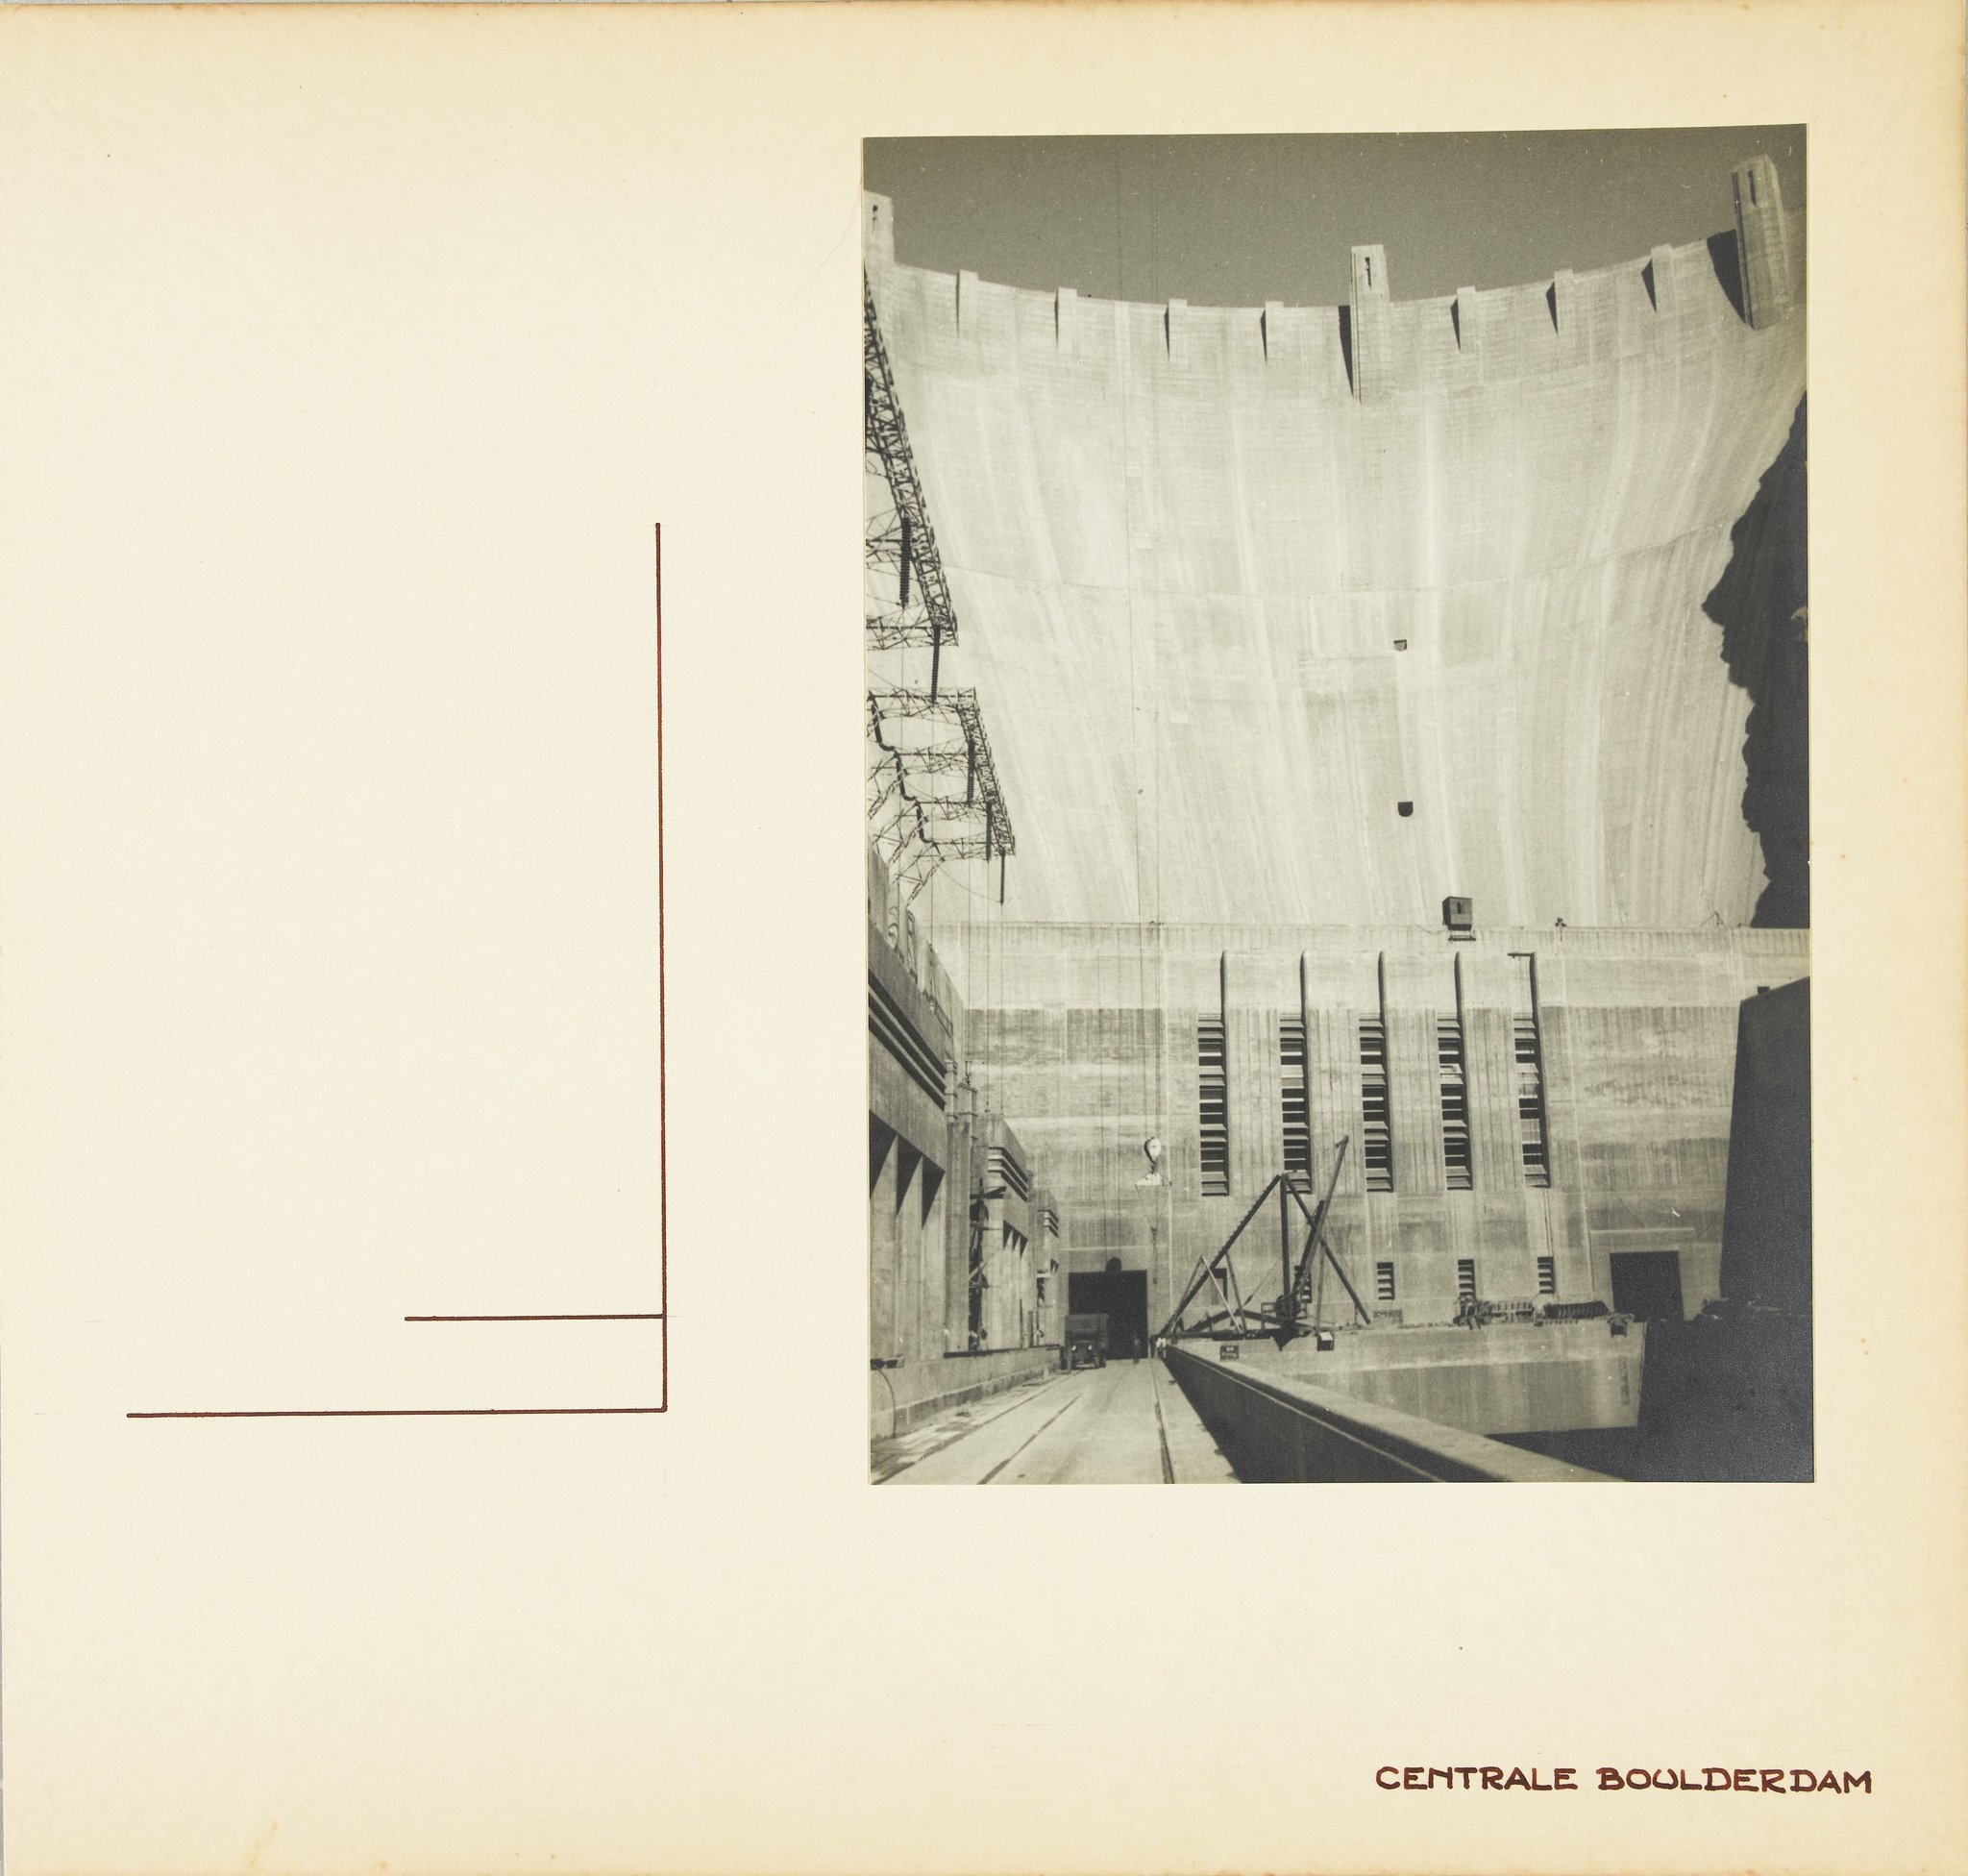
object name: photograph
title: Boulder Dam, Arizona/Nevada, Verenigde Staten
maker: wouter cool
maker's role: engineer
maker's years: 1877-1947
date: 1936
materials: cardboard, paper, photographic support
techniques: gelatin silver print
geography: united states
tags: dam (in canal)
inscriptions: title: ‘CENTRALE BOULDERDAM’